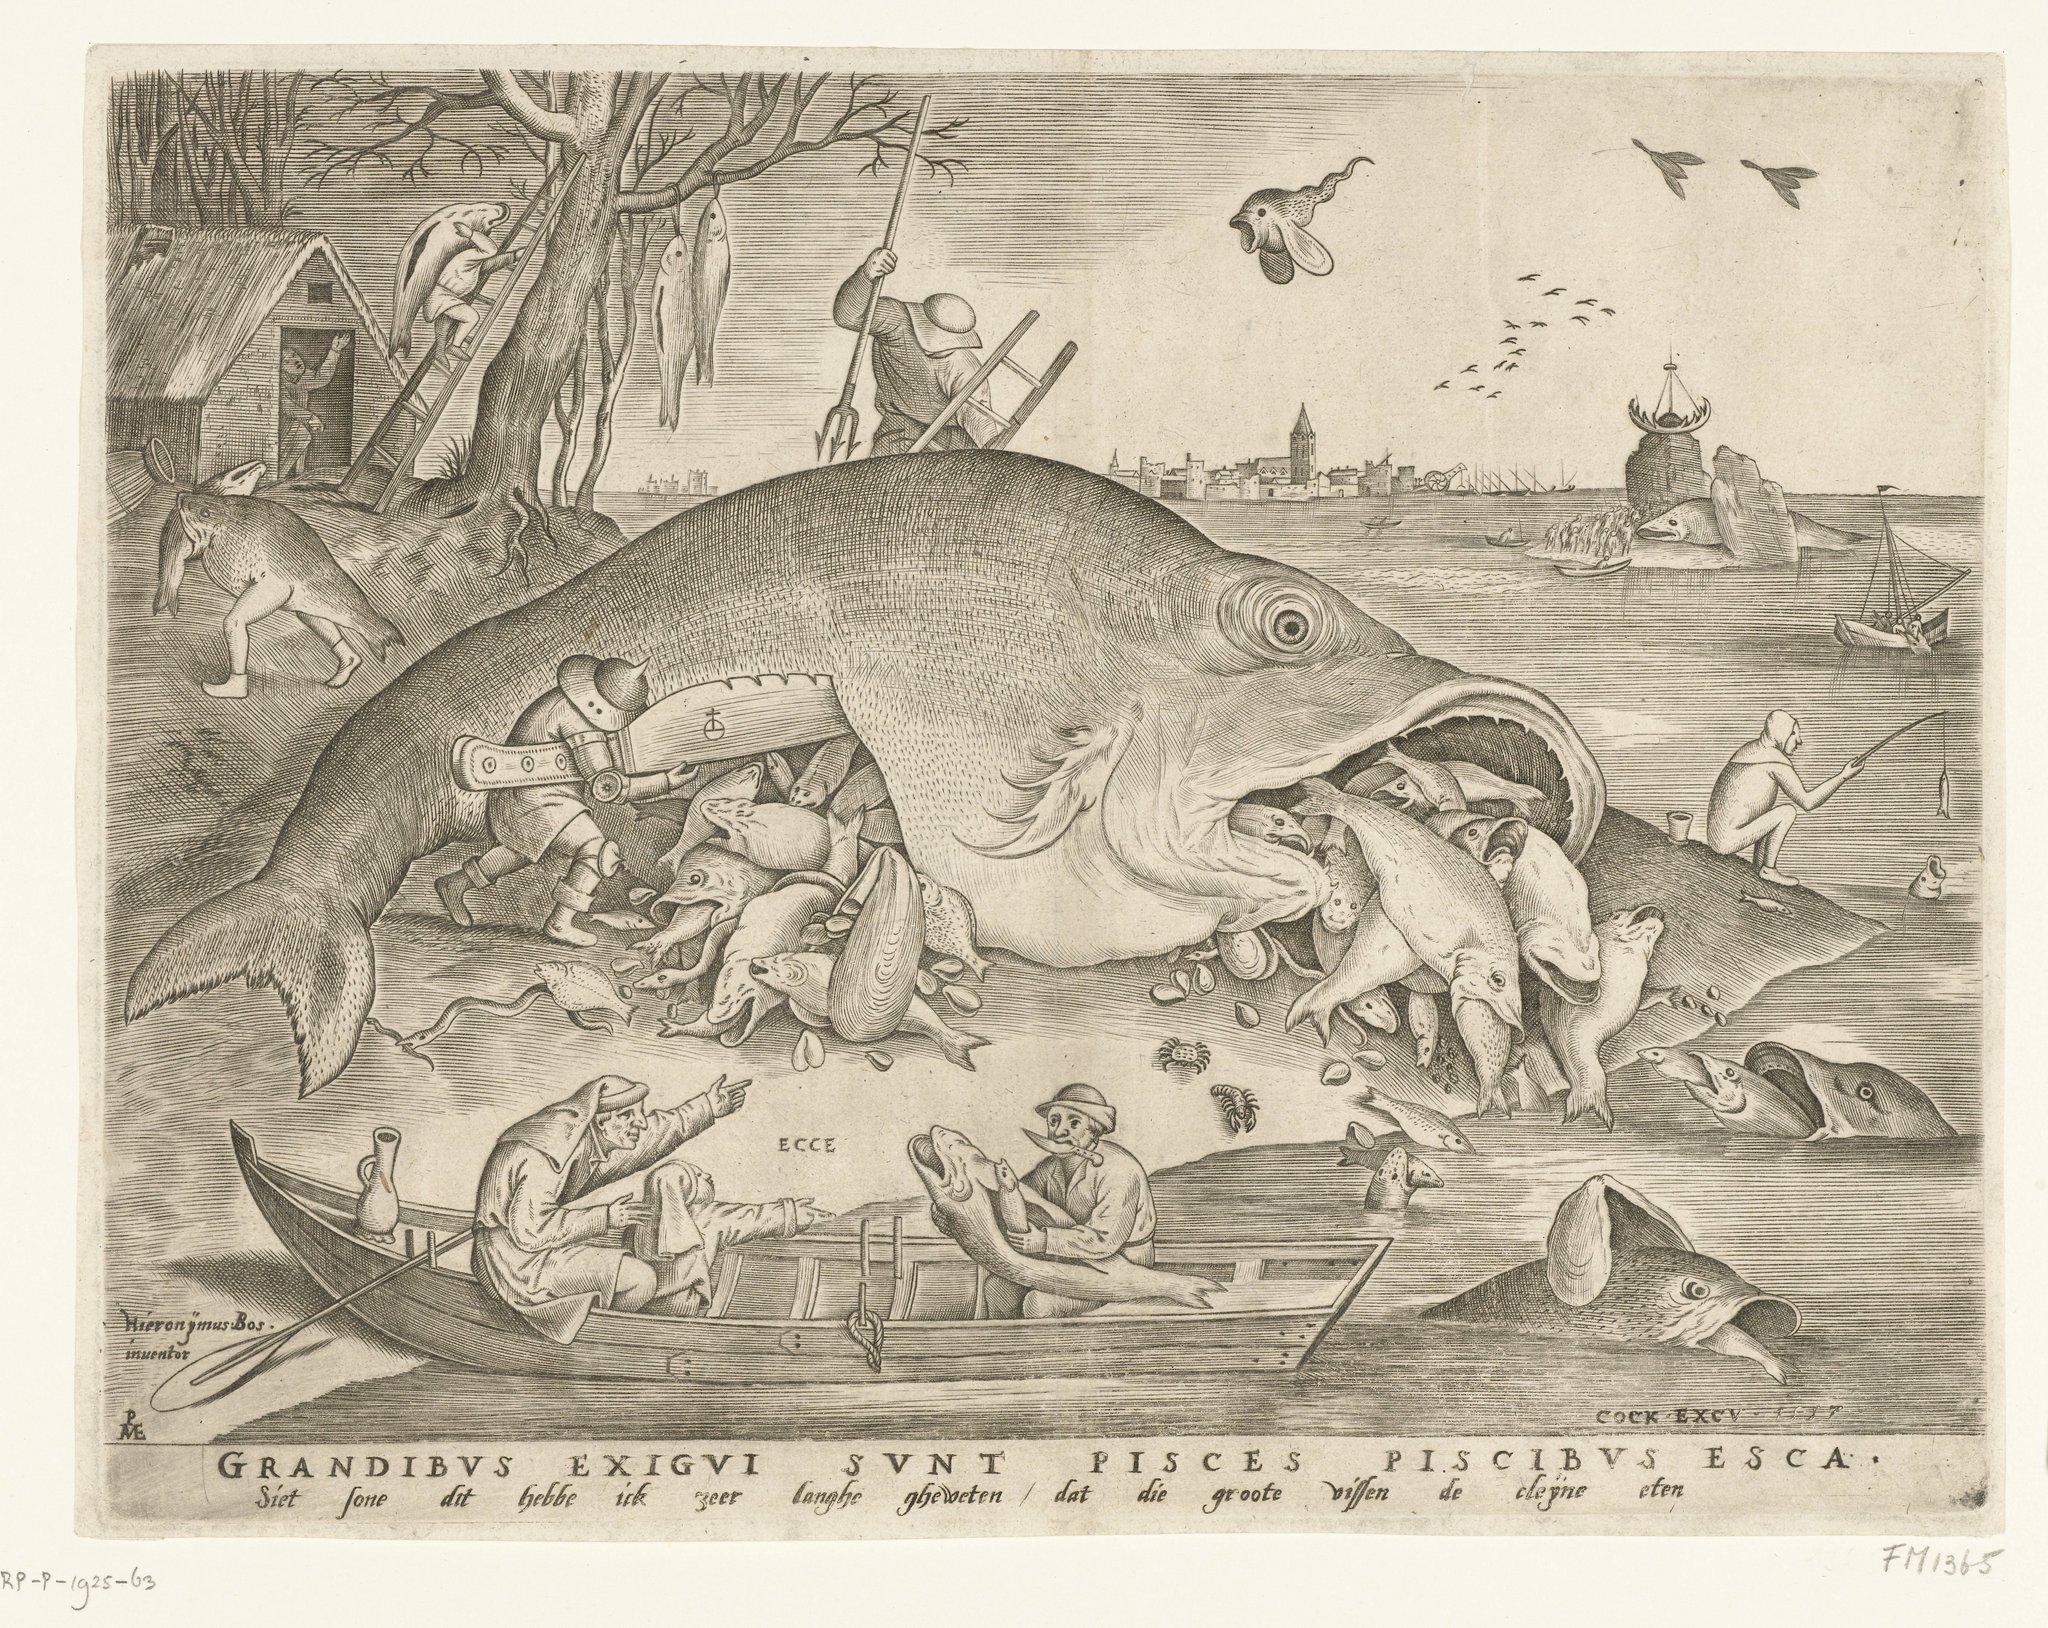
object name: print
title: Big Fish Swallow Small Fish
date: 1557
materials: paper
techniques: engraving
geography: low countries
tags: commercial fishery, monsters larger than normal, fishes, proverbs, sayings, etc.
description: Seated in a boat in the foreground, a father is telling his son some harsh facts about the ways of world: the powerful oppress the weak, the rich devour the poor – or, as the legend explicitly states, ‘Big fish swallow small fish’.